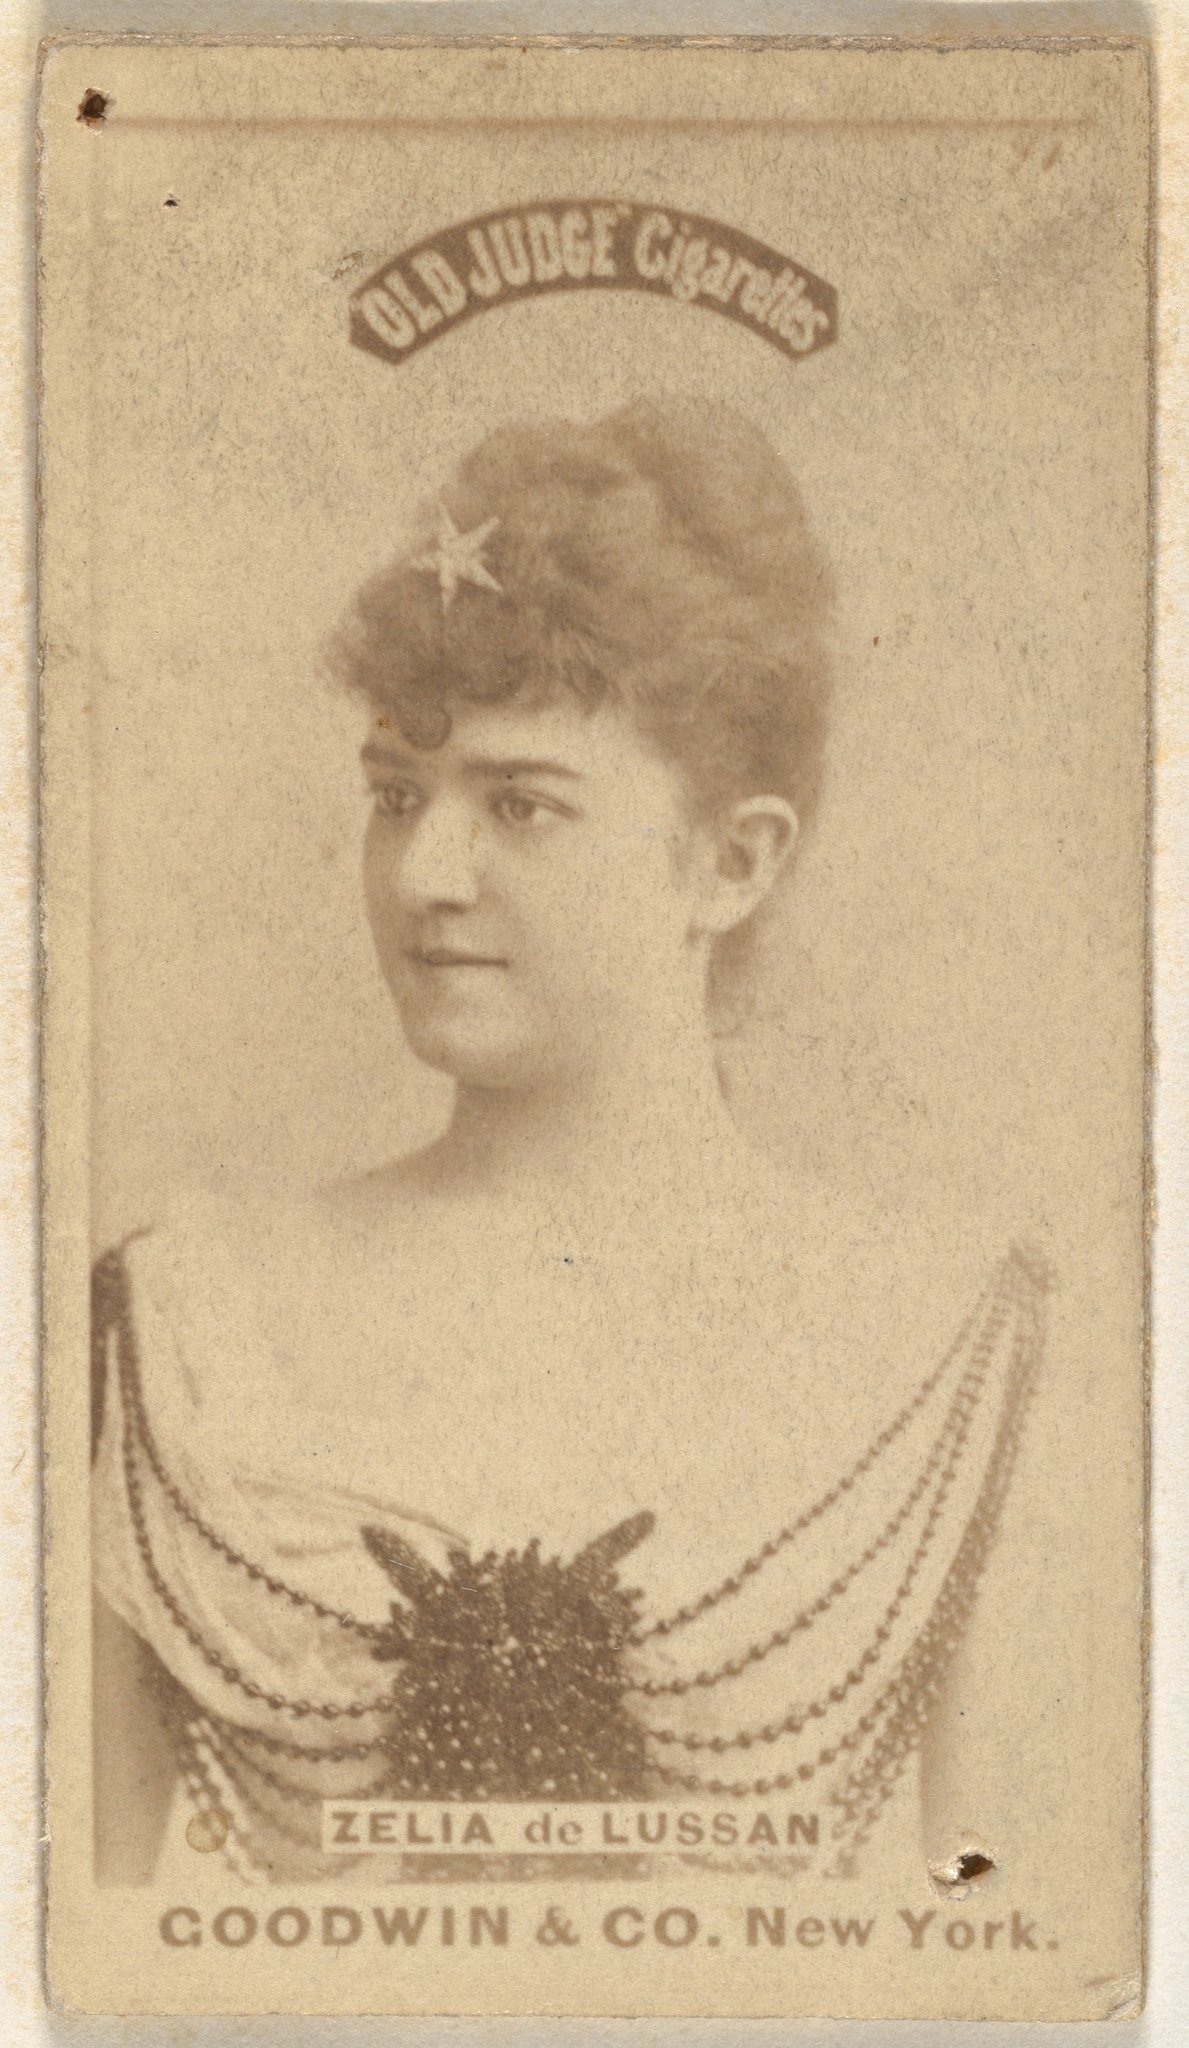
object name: photograph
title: Zelia de Lussan, from the Actors and Actresses series (N171) for Old Judge Cigarettes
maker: goodwin & company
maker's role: publisher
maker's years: 1850-1950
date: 1886-1890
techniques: albumen silver print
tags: portraits,women,actresses